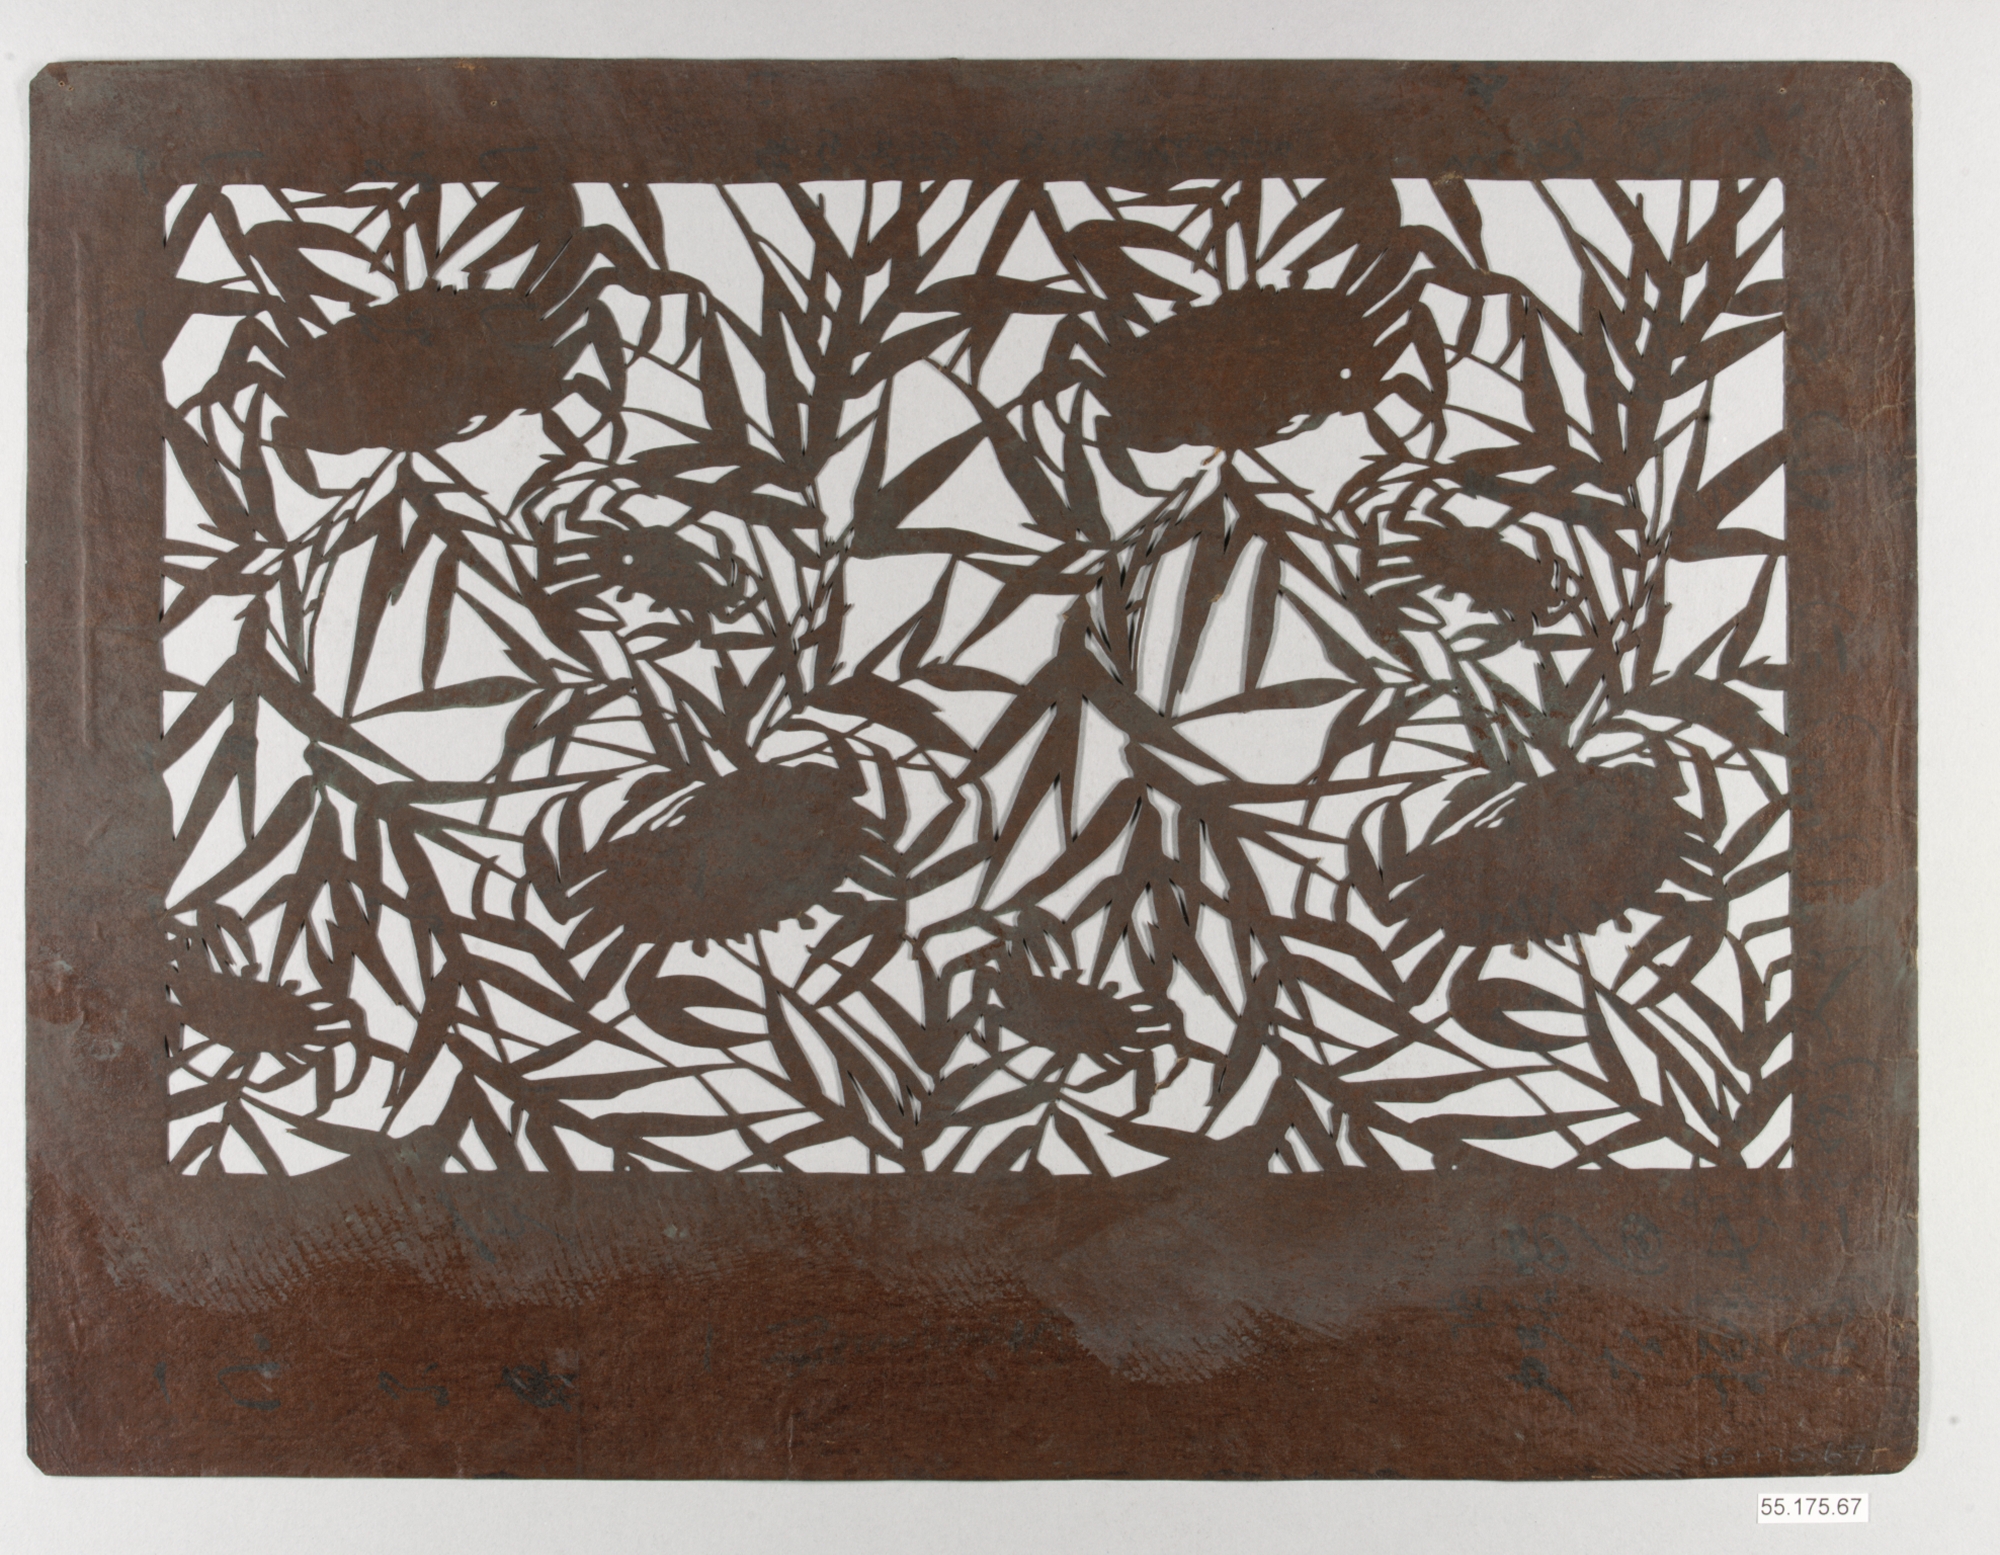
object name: stencil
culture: japanese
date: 1801-1900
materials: paper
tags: crabs